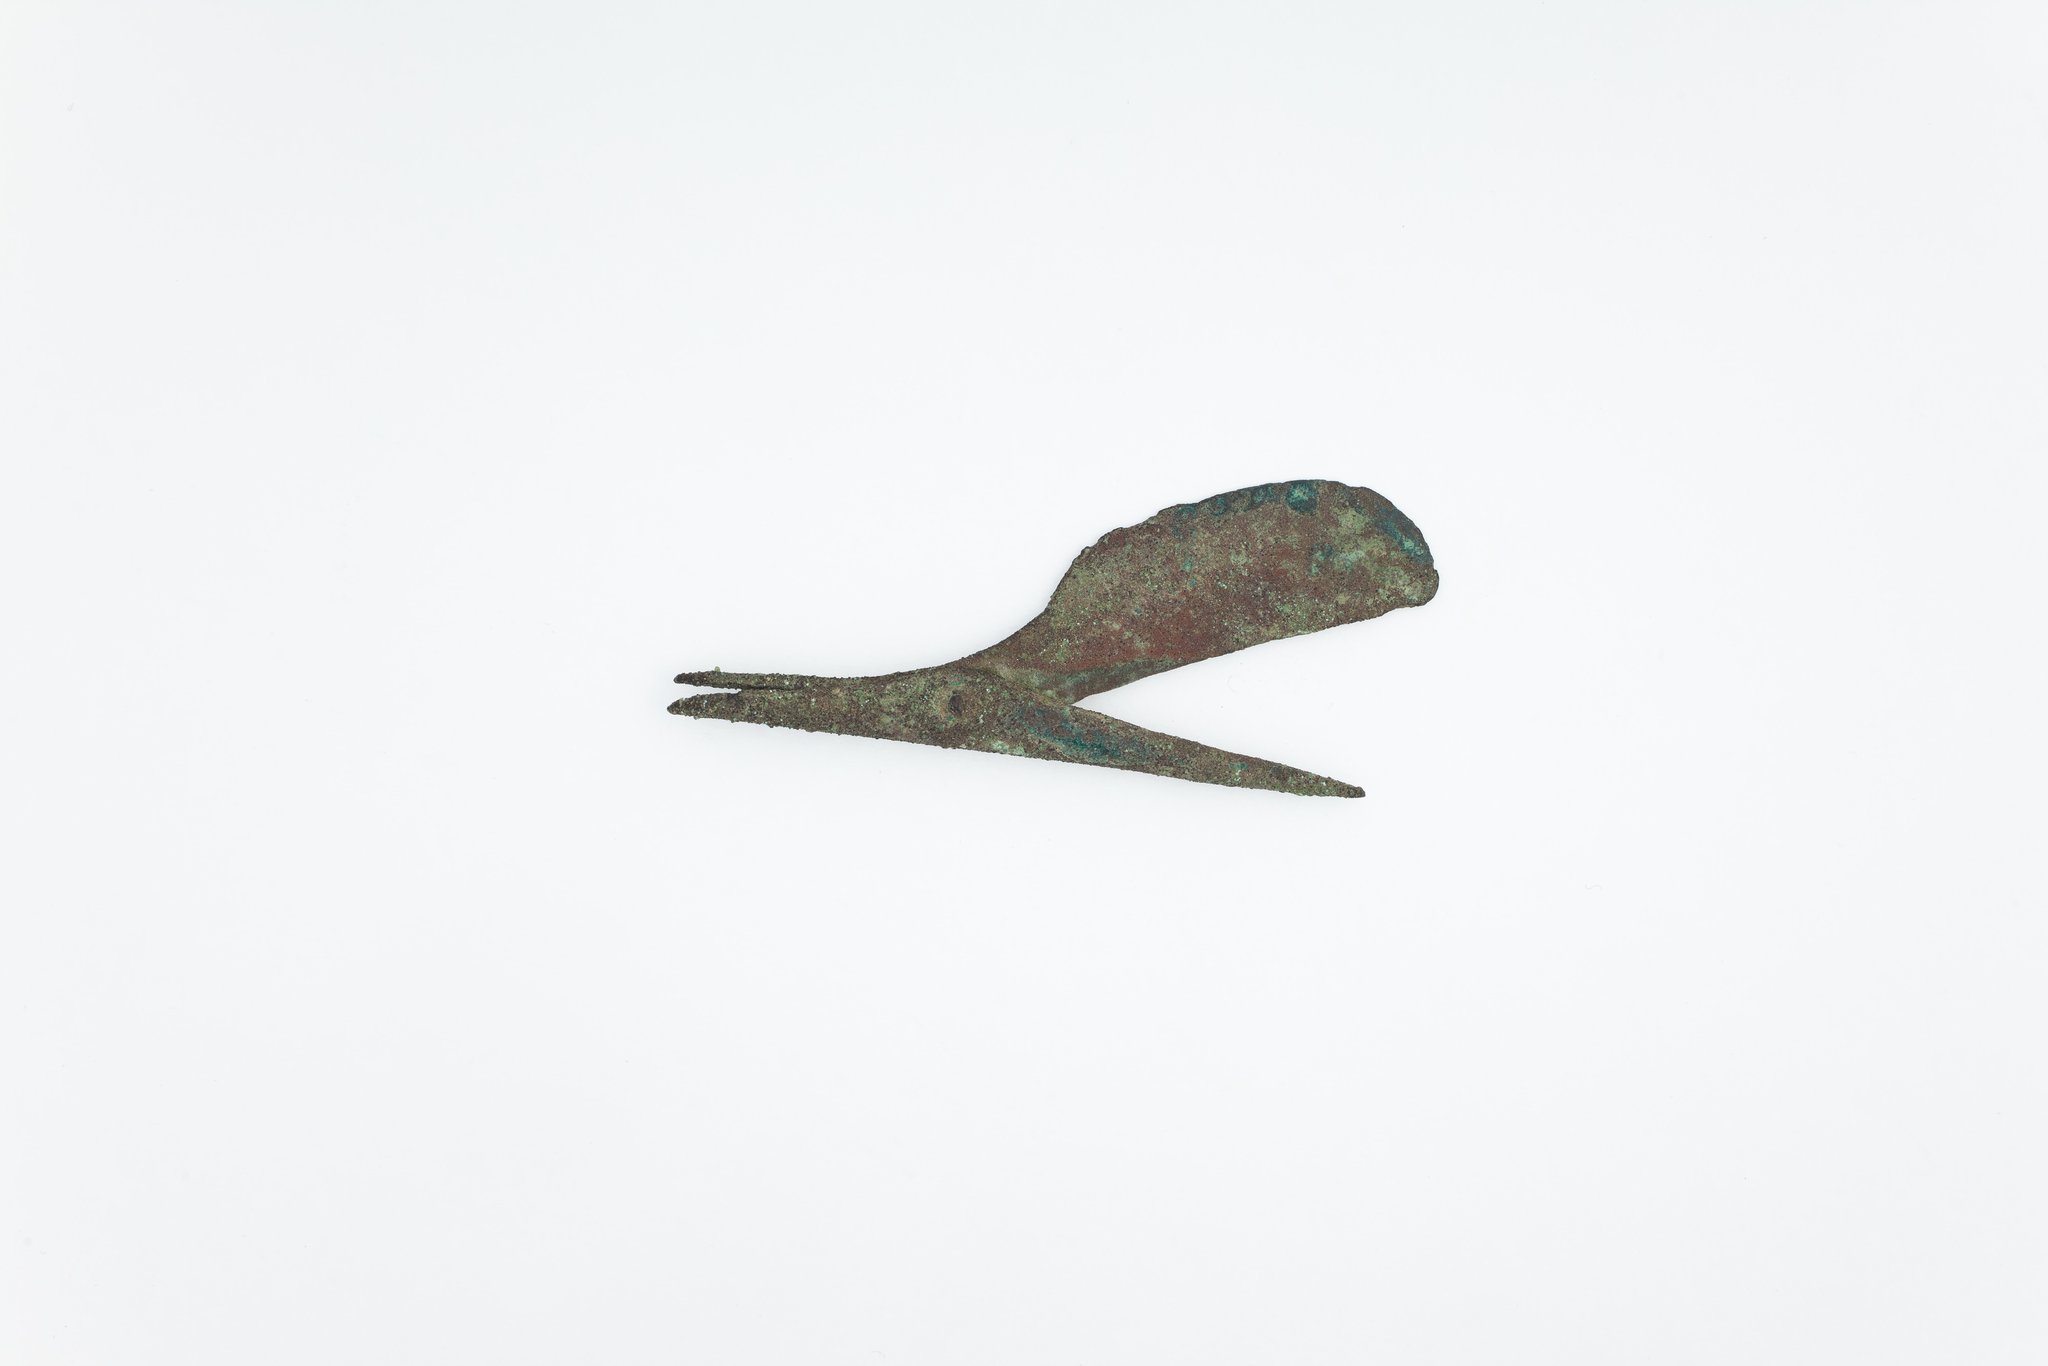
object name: tweezer razor, razor, tweezer, hair curler, knife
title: Razor-tweezer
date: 1550-1295 BCE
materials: bronze, copper alloy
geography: egypt